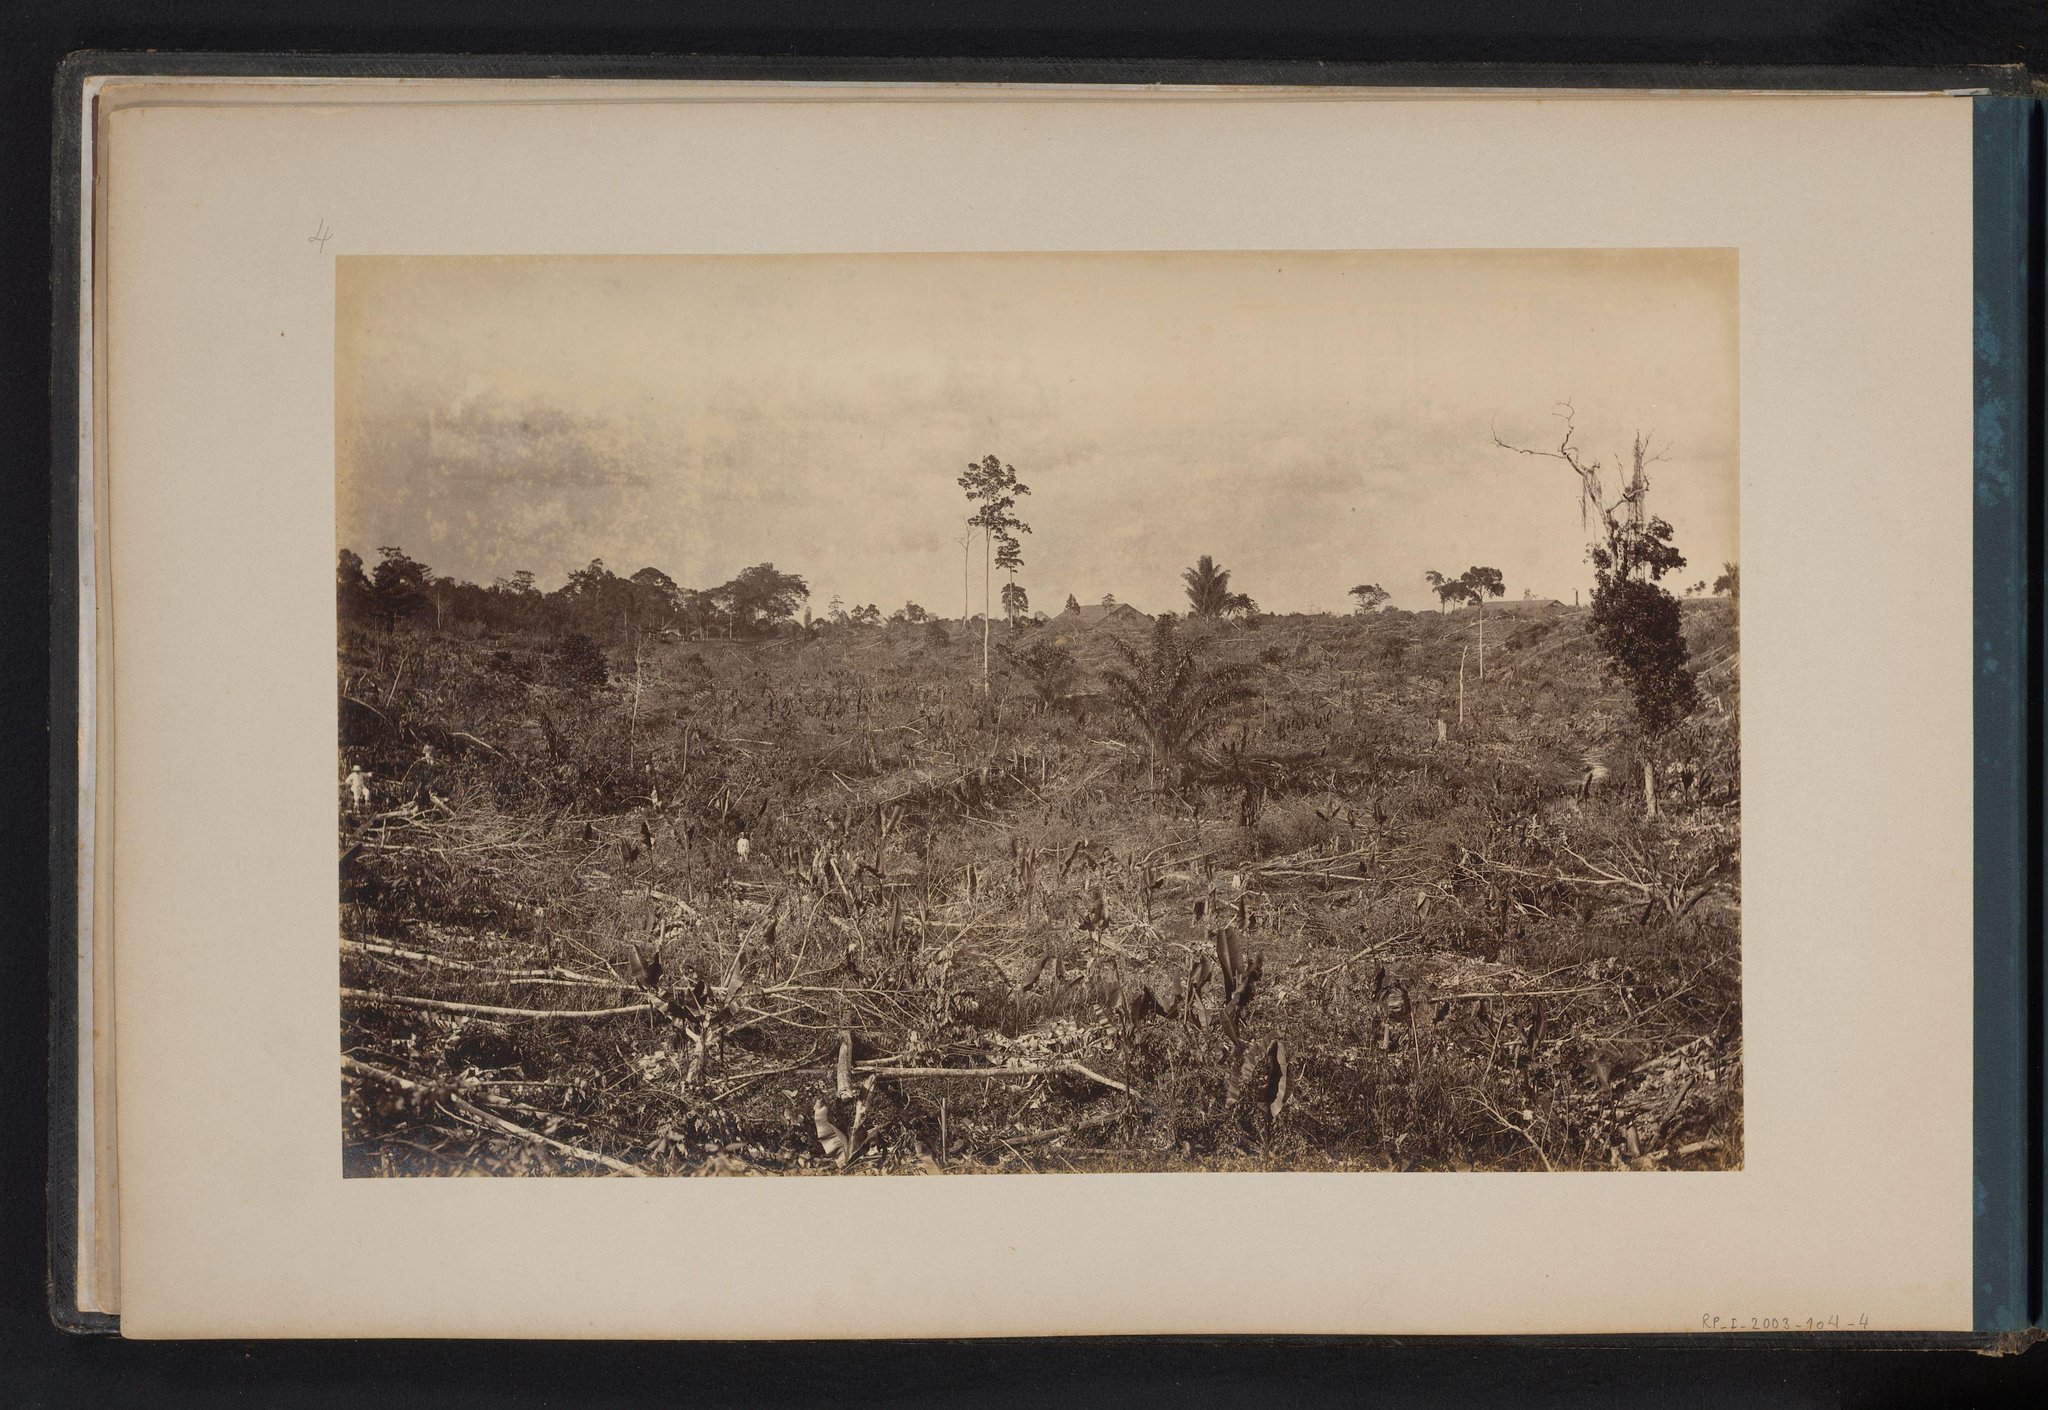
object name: album leaf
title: Gekapt oerwoud in Quali Mintchirim, Sumatra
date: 1890-1900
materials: cardboard, photographic support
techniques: albumen print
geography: sumatra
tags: chopping (industrial process), woodcutting, woodcutter ~ forestry, jungle, sumatra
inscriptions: number: ‘4’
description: In de lijst van afbeeldingen wordt deze foto beschreven met de woorden "Geschlagener Walt in Quala Mintchirim".